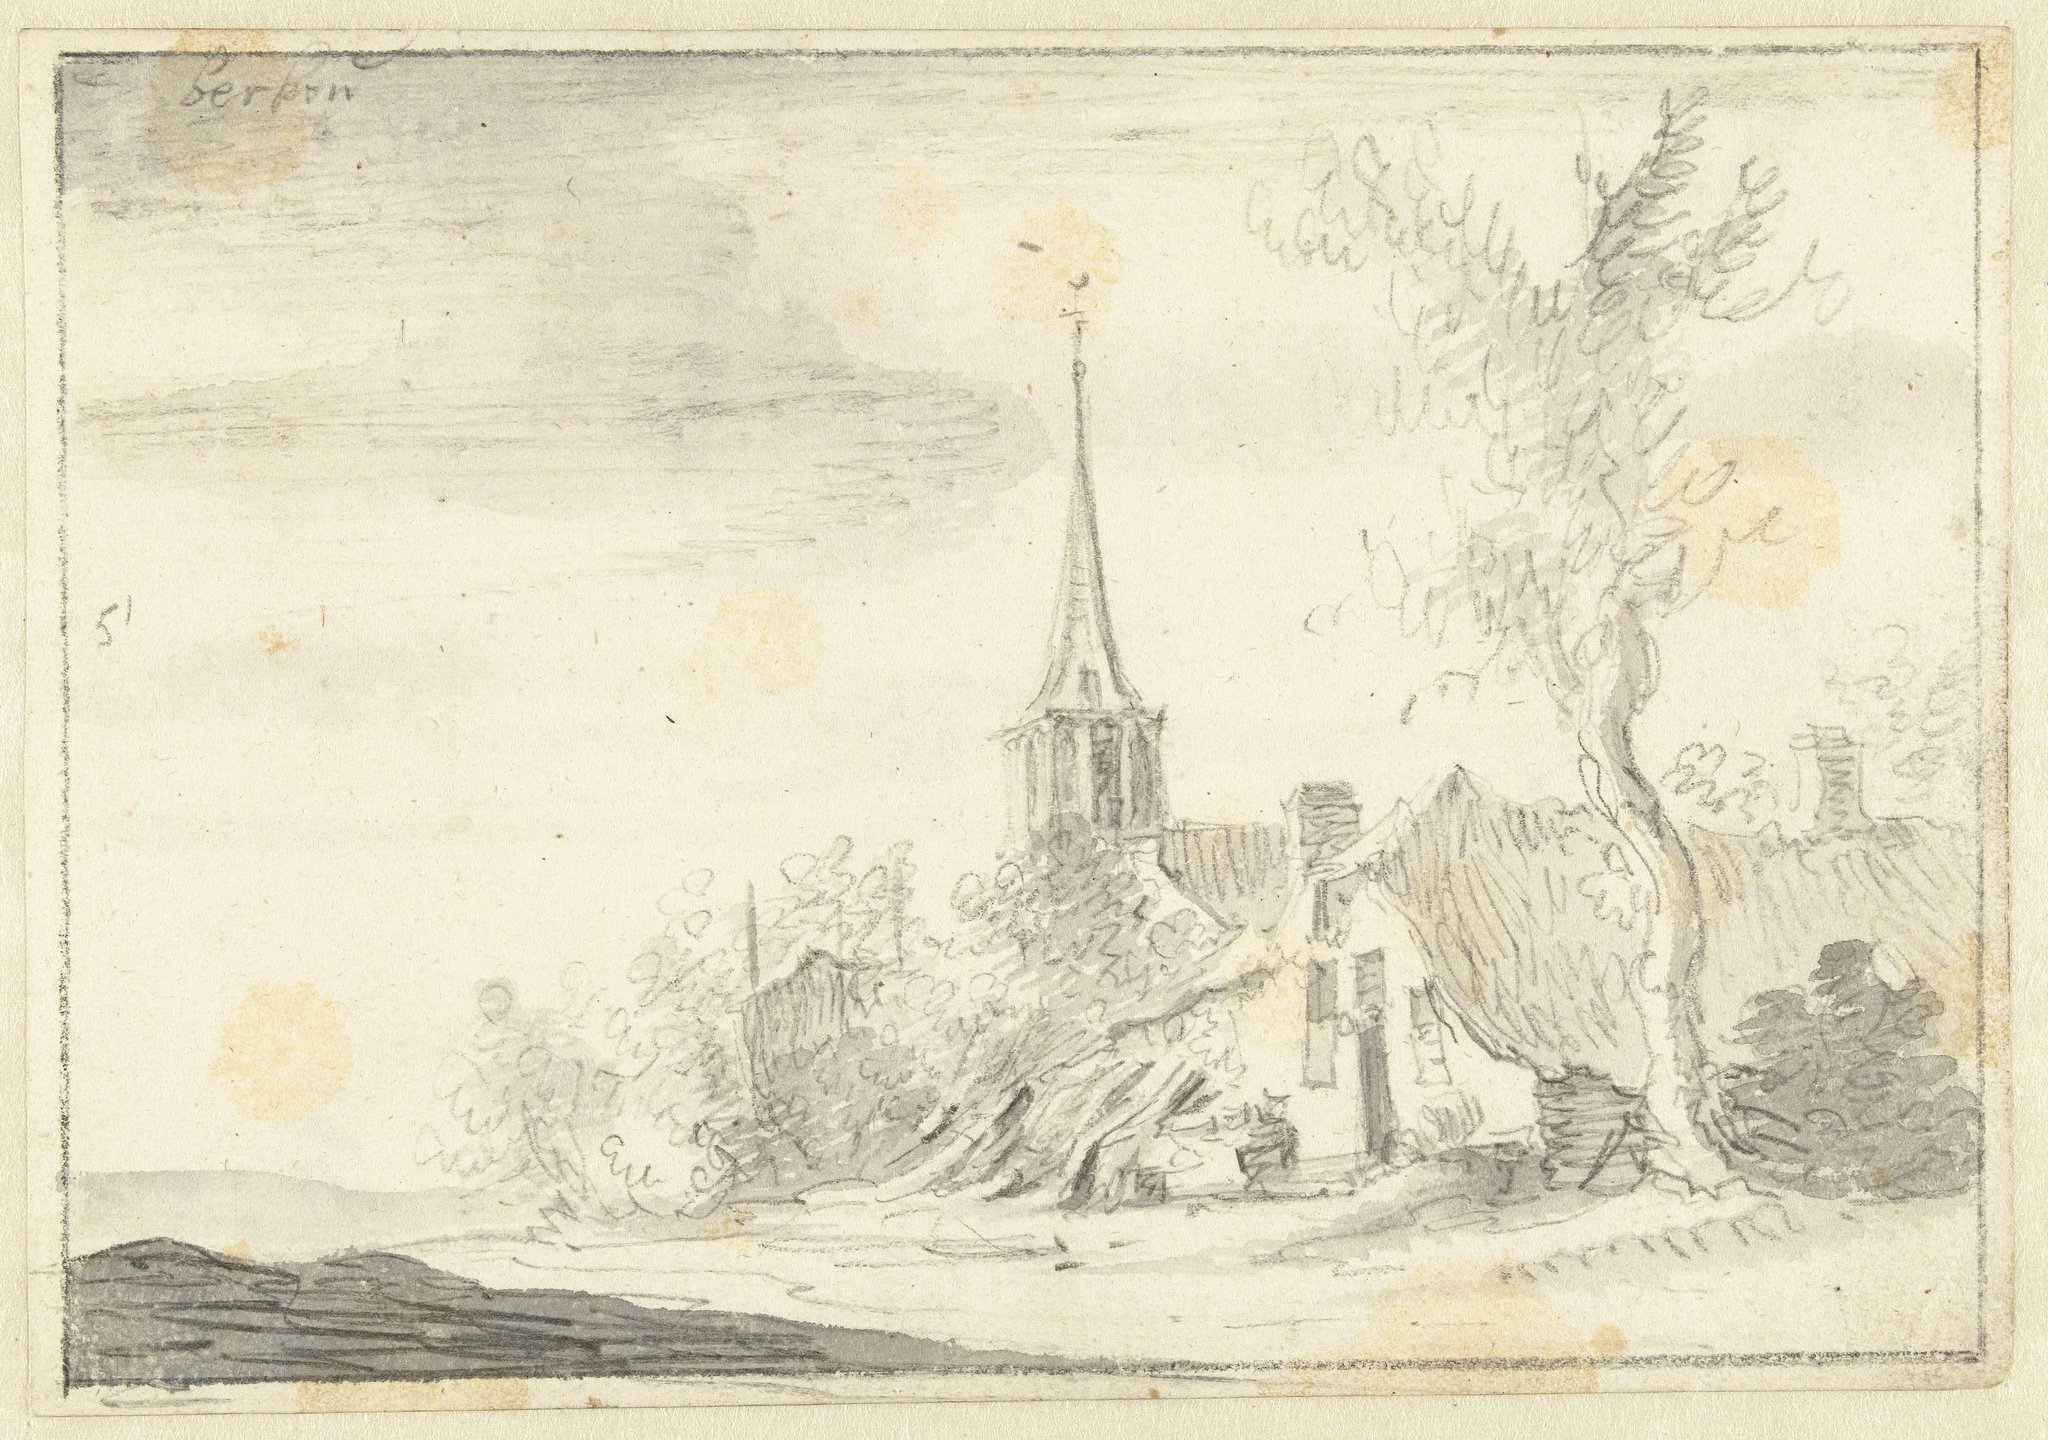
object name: drawing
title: Dorpsgezicht, in het midden een kerktoren met een hoge spits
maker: pieter de molijn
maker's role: draughtsman, painter, print maker, publisher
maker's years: 1595-1661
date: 1650-1660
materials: chalk, paper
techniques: brush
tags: prospect of village, silhouette of village, church (exterior)